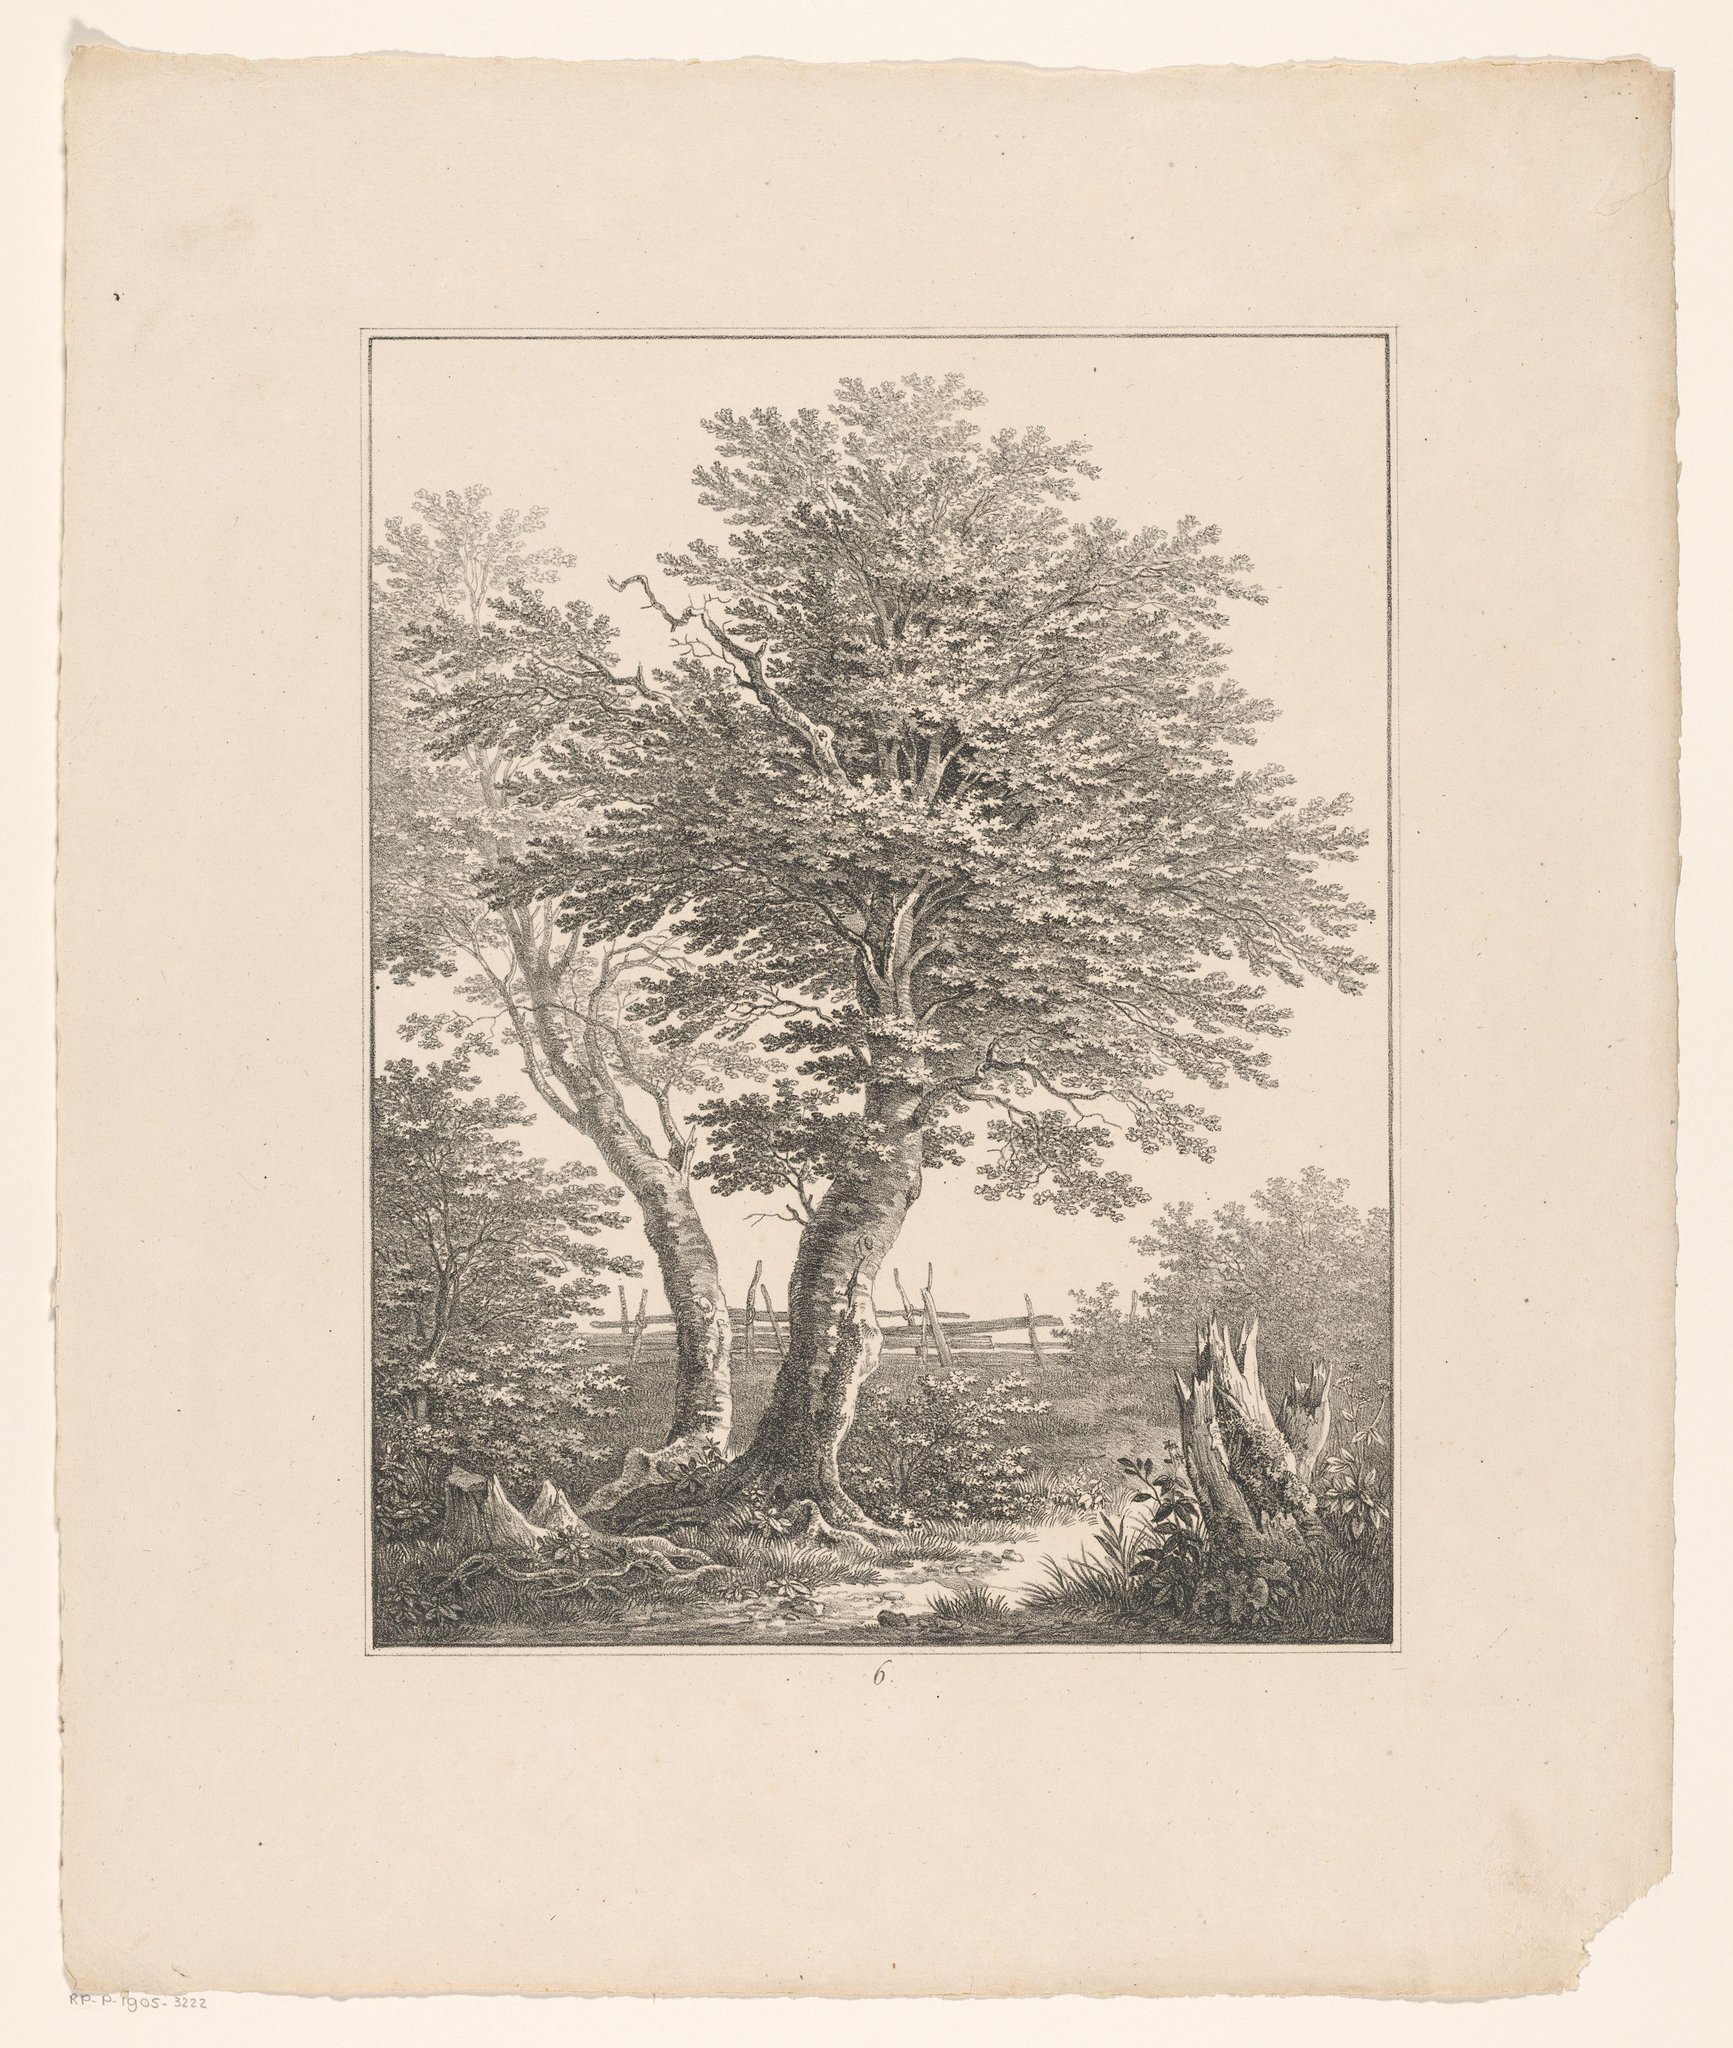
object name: print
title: Boomstudien / 1e Bundel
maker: adrianus van der koogh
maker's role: draughtsman, print maker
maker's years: 1796-1831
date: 1826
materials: paper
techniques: lithograph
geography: dordrecht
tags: trees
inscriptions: collector's mark: Lugt 2228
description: Twee bomen in een landschap met in de achtergrond een hek. Rechts afgebroken boomstammen.